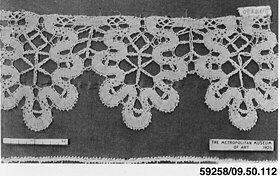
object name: fragment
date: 1601-1700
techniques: lace